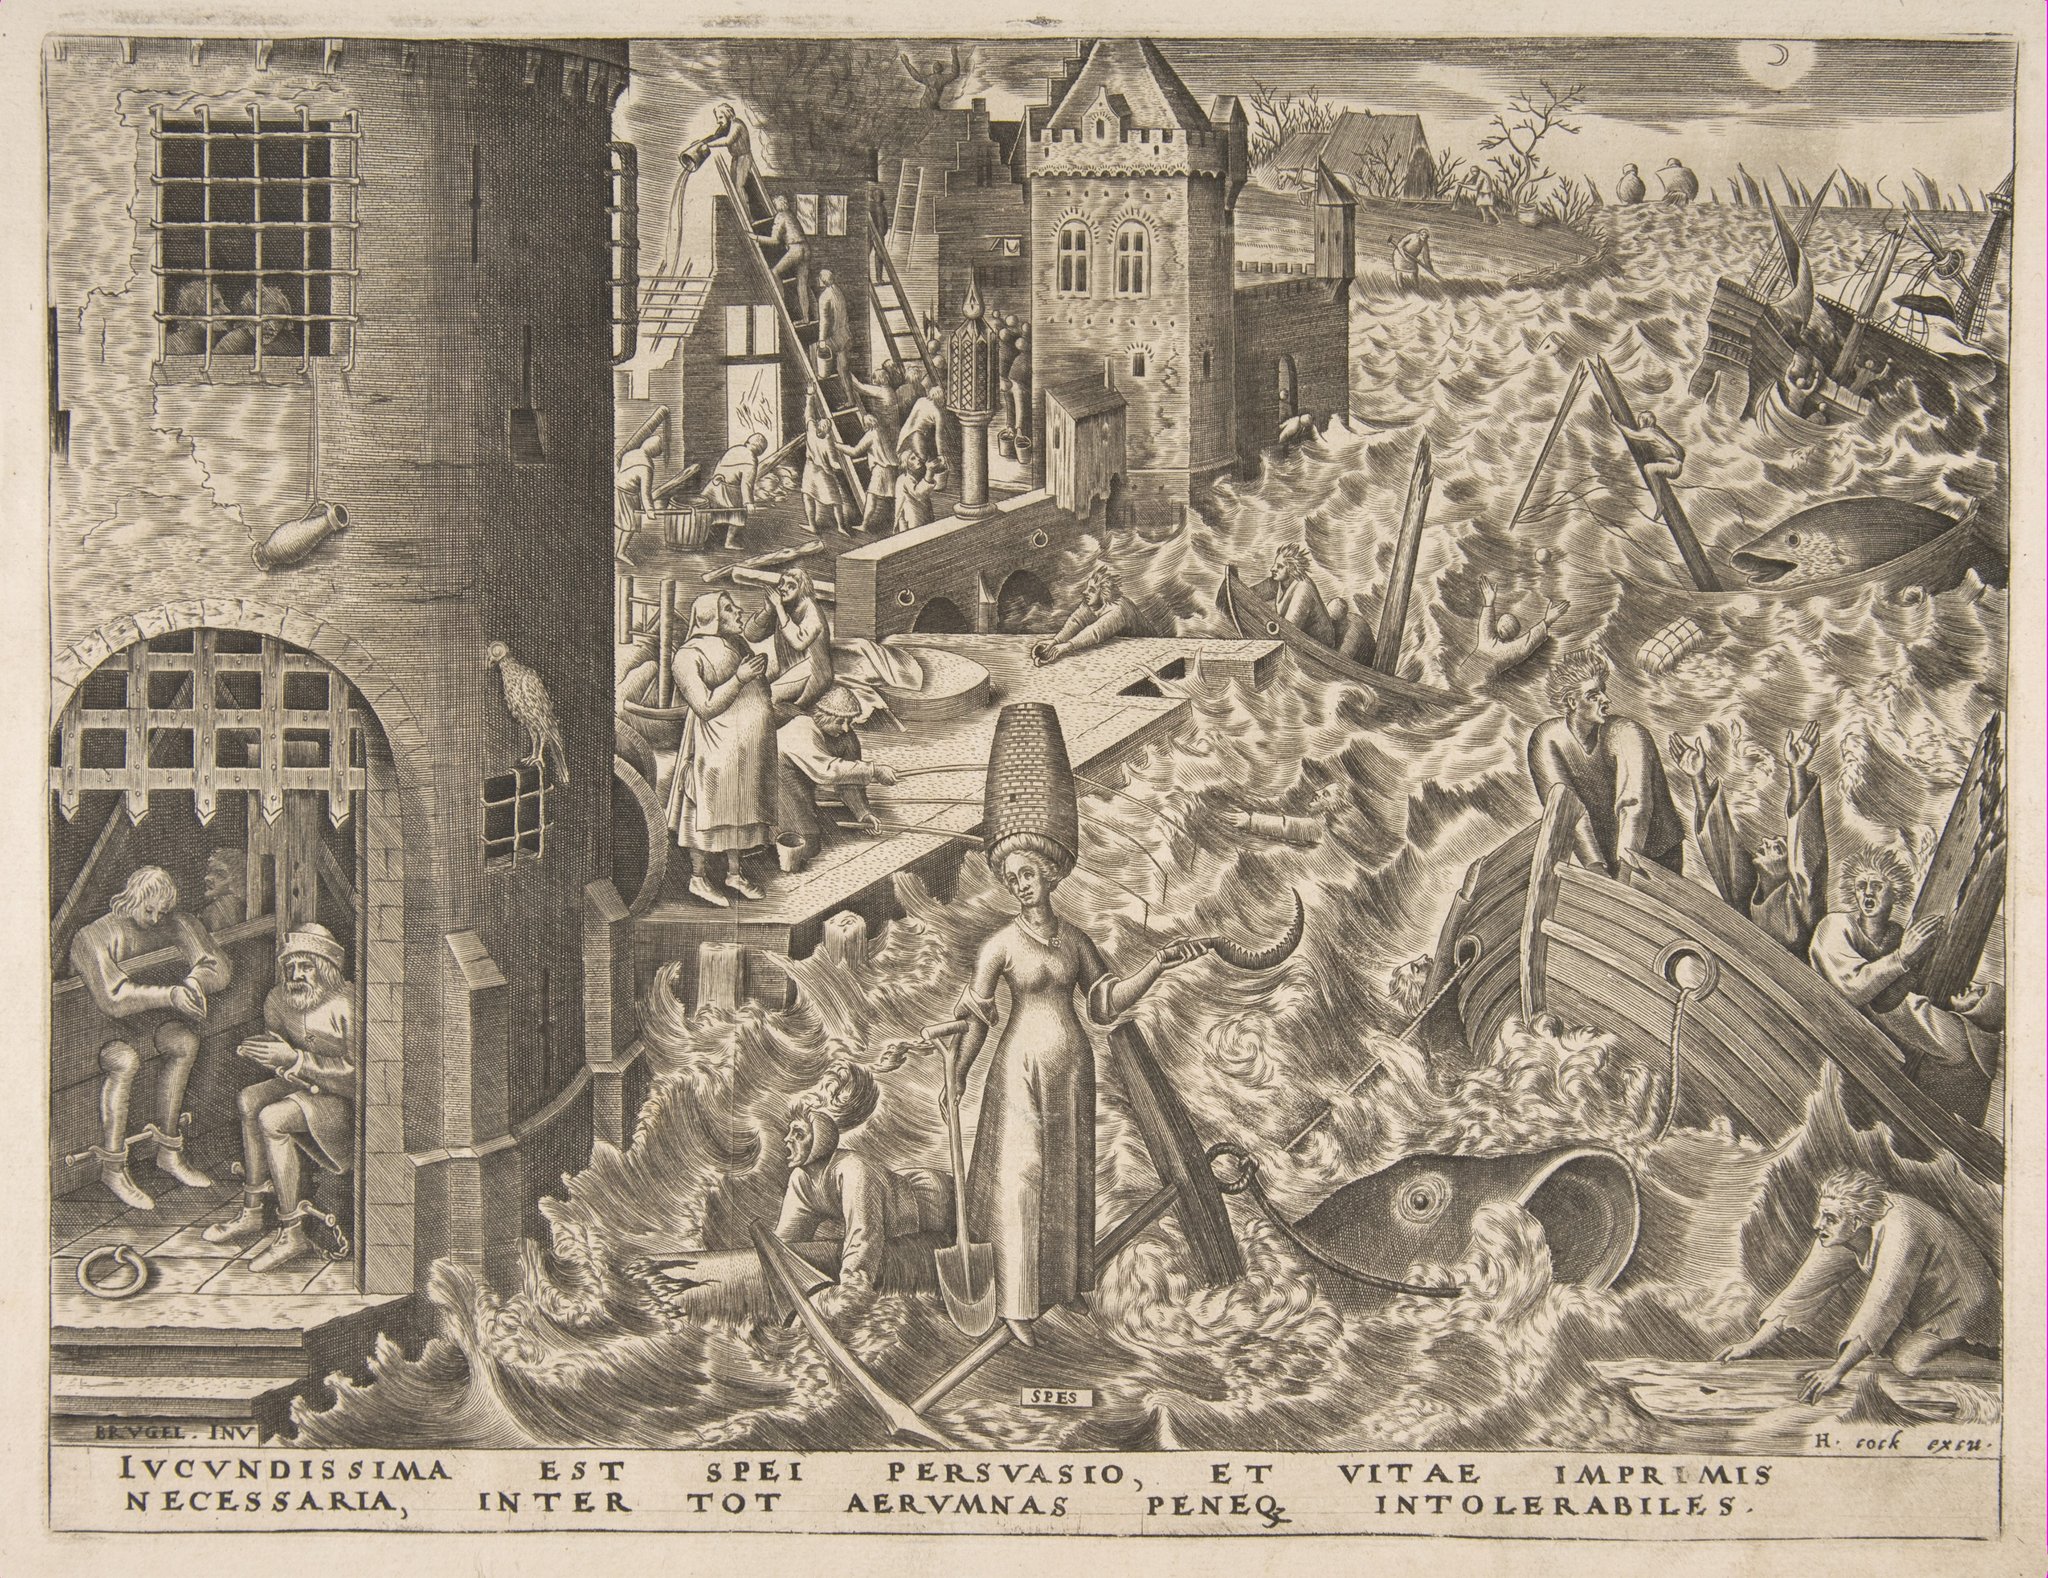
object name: print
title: Hope (Spes) from The Virtues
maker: pieter bruegel the elder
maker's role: artist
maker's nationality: netherlandish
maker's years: 1525-1569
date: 1559-1560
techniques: engraving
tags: men,women,fish,boats